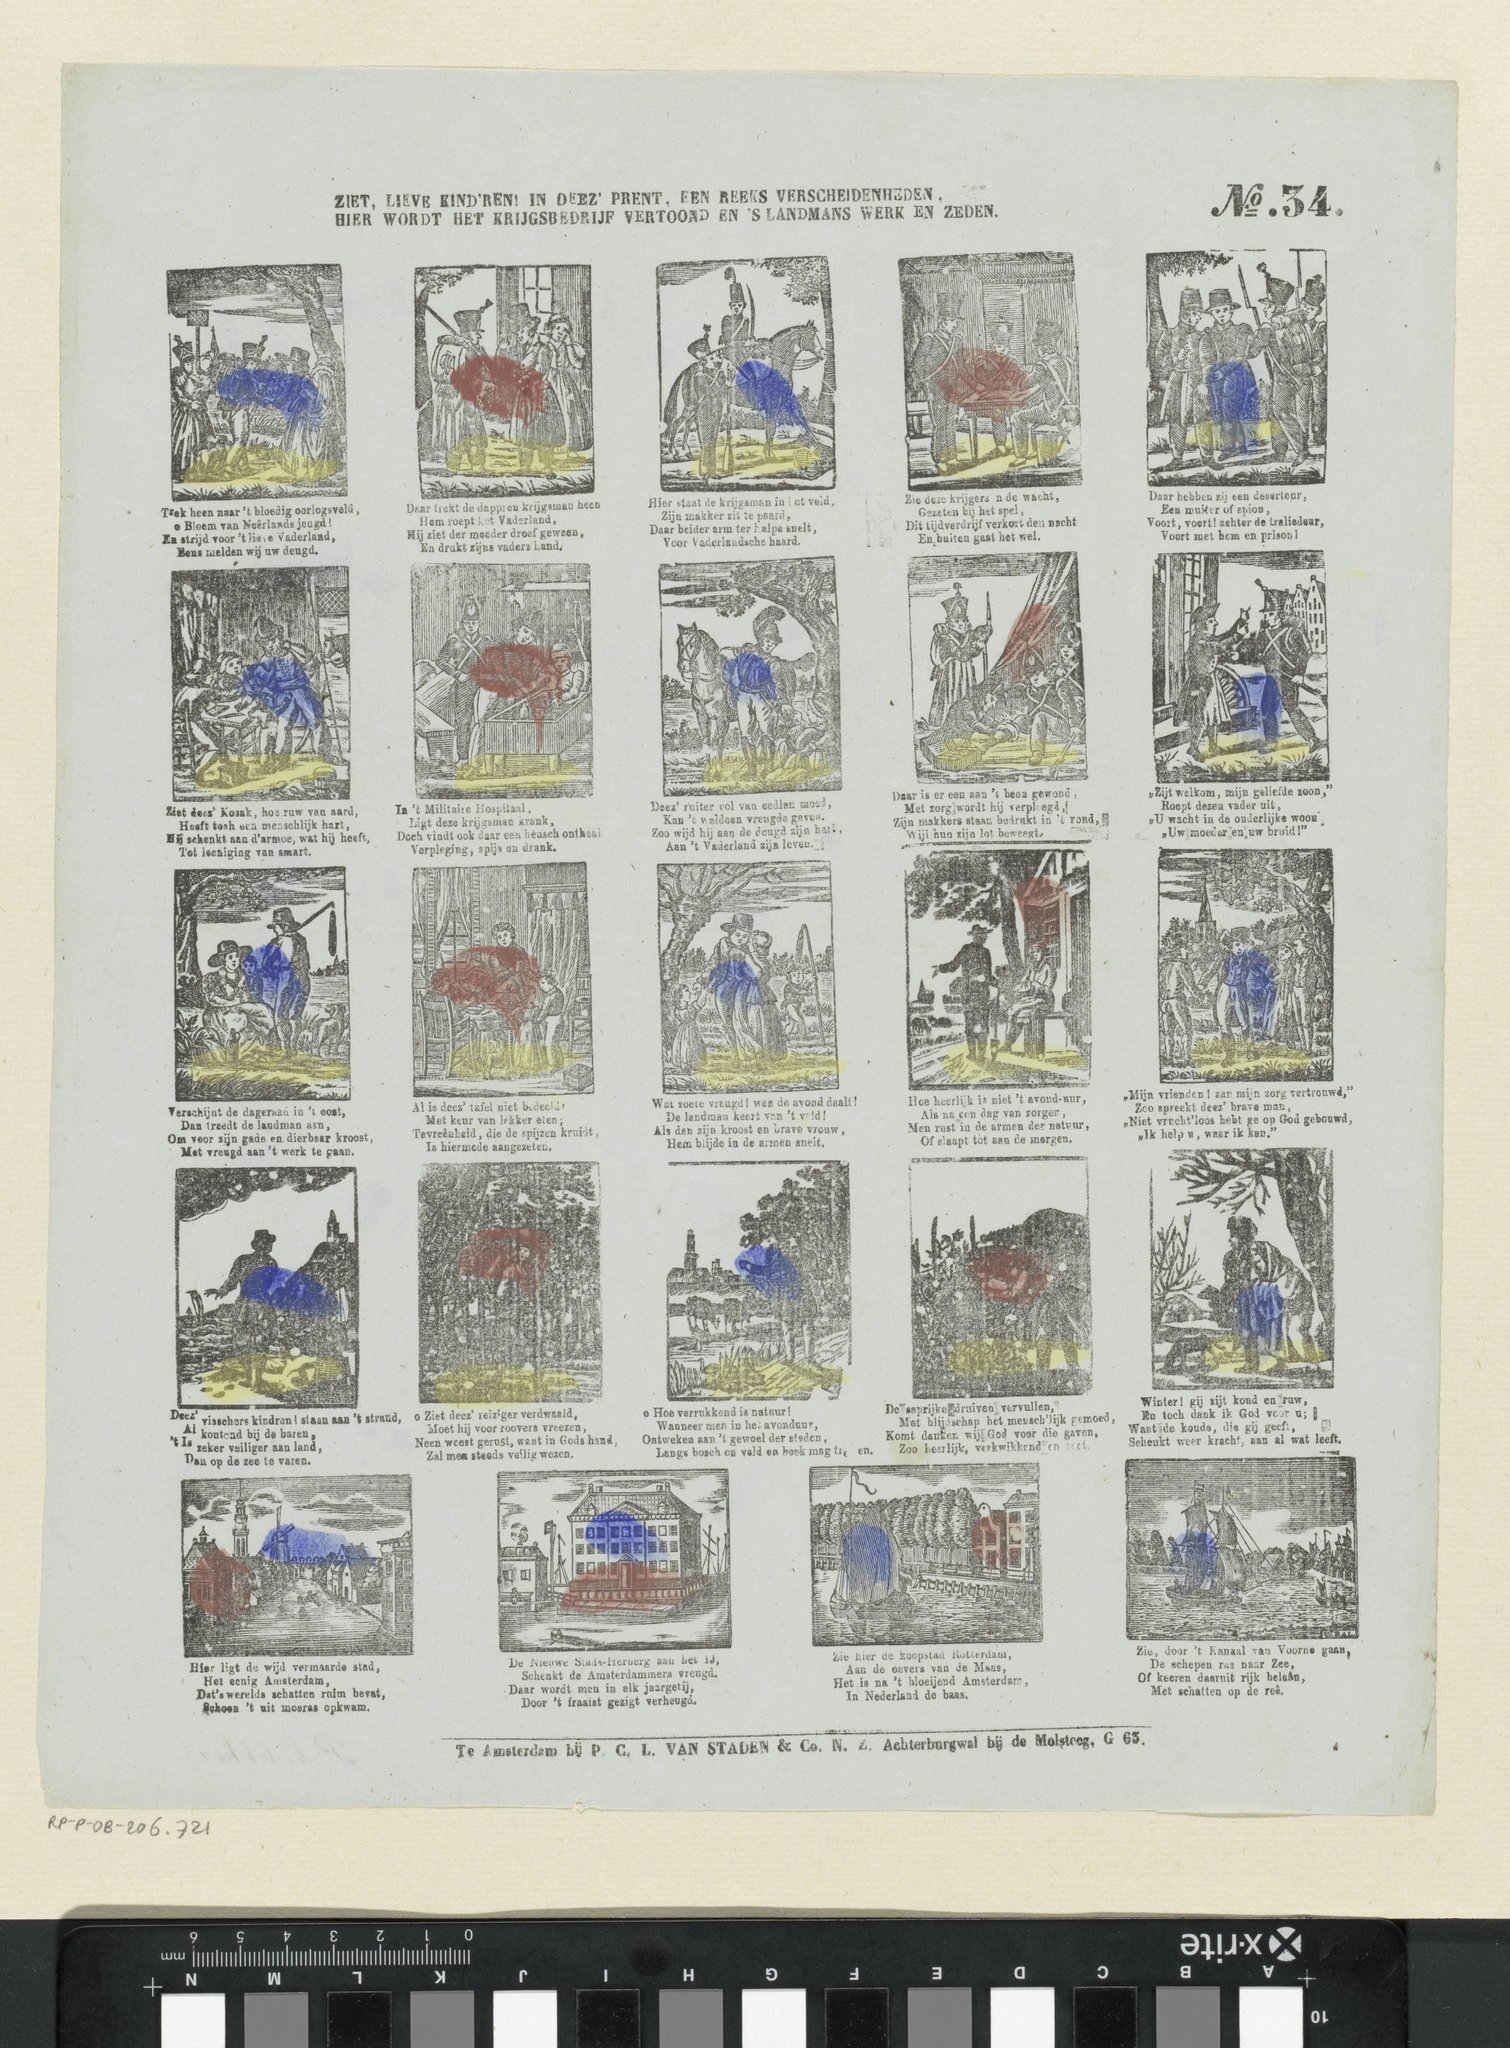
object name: popular print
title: Ziet, lieve kind'ren! in deez' prent, een reeks versgeidenheden, / Hier wordt het krijgsbedrijf vertoond en 's landmans werk en zeden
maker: willem bal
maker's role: print maker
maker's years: 1808-1897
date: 1850-1870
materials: paper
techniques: colour, letterpress printing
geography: netherlands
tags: farmers, ships (in general), the soldier; the soldier's life, rural life, amsterdam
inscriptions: collector's mark: Lugt 2760, inscription: ‘P. Leidekker’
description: Blad met 24 voorstellingen van verschillende aard, zoals voorstellingen van militairen en van het boeren leven. Onder elke afbeelding een vierregelig vers. Rechtsboven genummerd: No. 34.